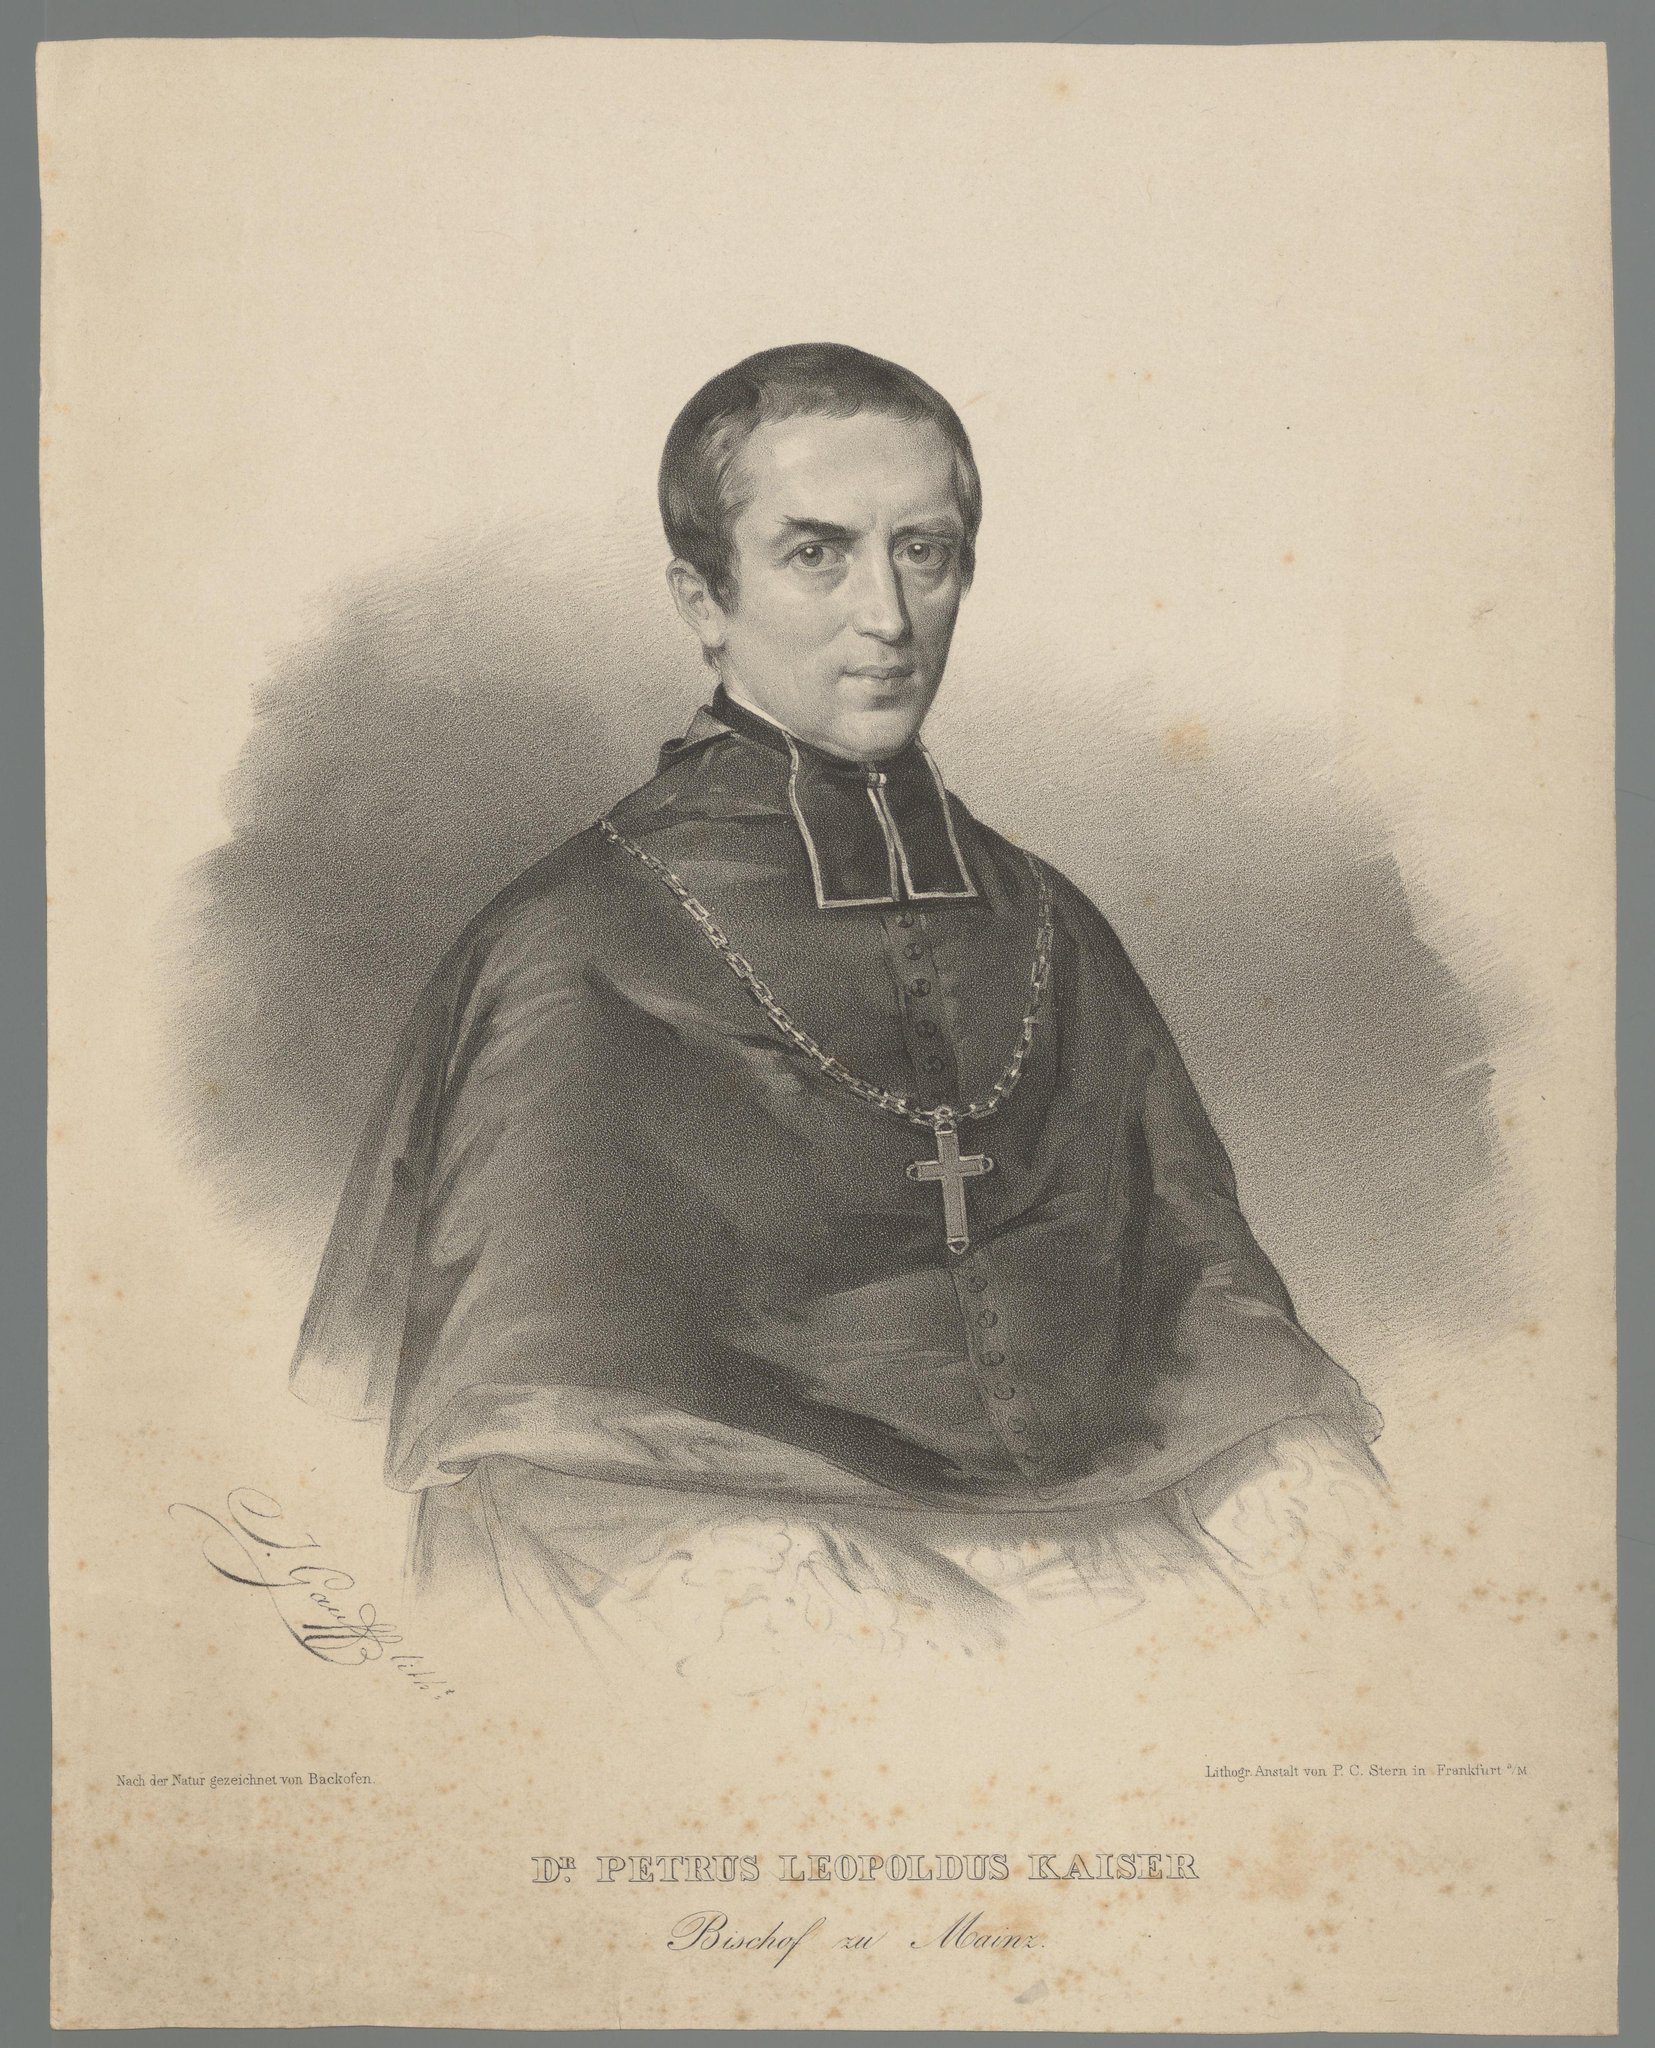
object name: print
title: Portret van Peter Leopold Kaiser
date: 1814-1858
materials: paper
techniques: lithograph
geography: frankfurt am main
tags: clergyman, archbishop, bishop, etc. (roman catholic), adult man, historical persons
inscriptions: collector's mark: Lugt 2228